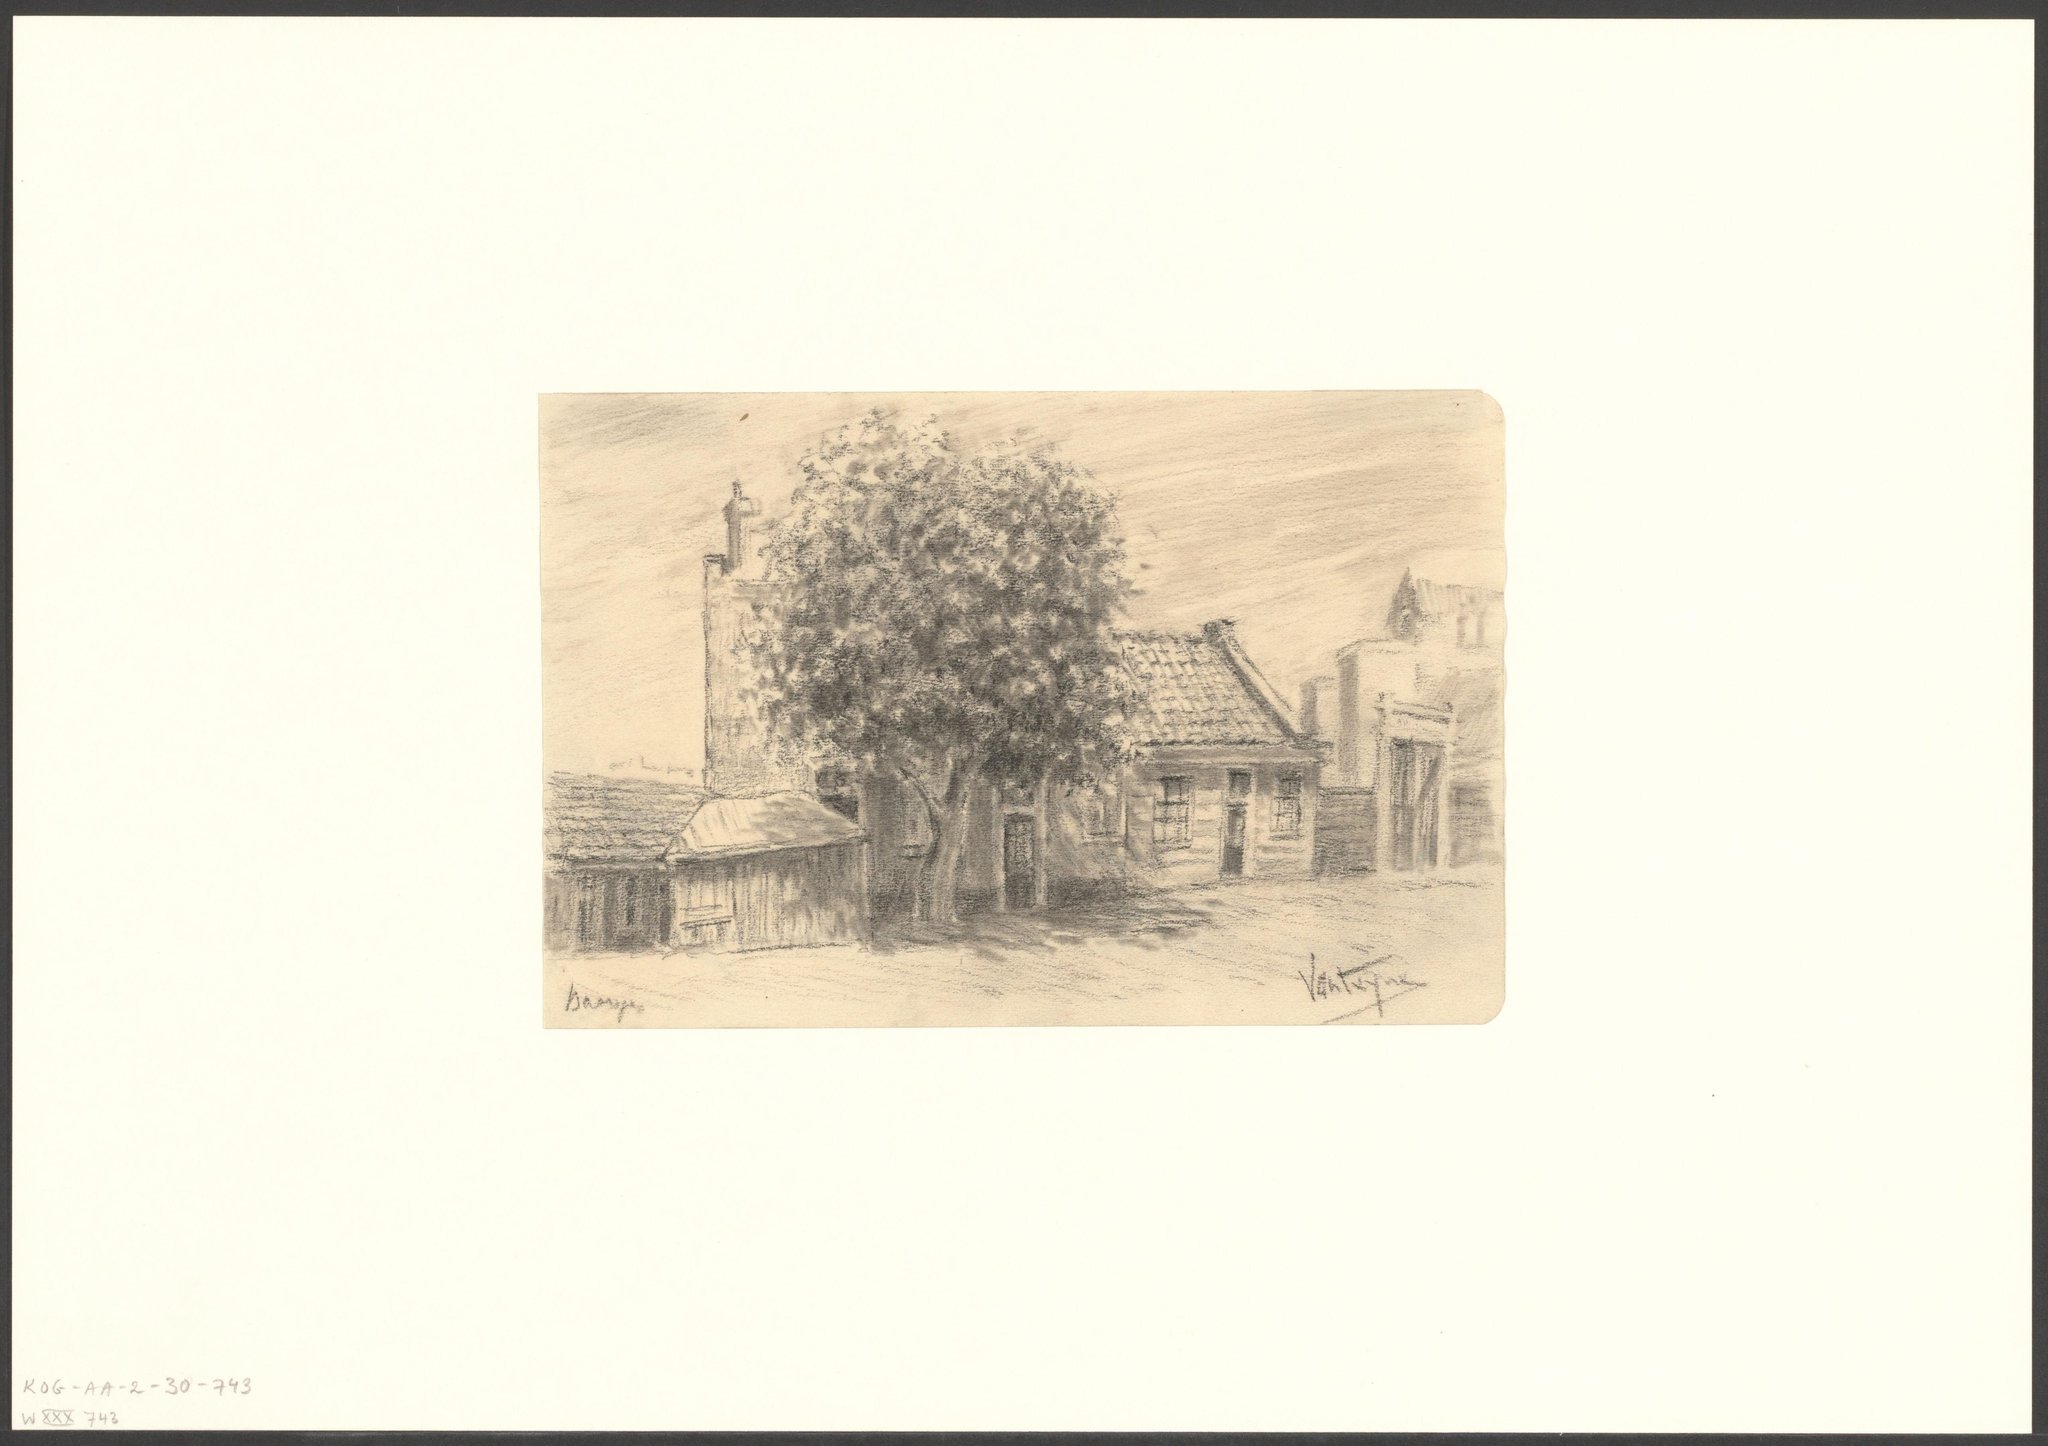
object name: drawing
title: Gezicht op de Baarsjesweg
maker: anthonie van teijn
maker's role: draughtsman, painter, print maker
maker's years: 1863-1943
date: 1906-1927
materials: chalk, paper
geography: amsterdam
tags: city-view in general; 'veduta', road, path, façade (of house or building)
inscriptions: inscription: ‘Baarsjes weg. 130 (...) Juni 1927. / vanEck’, collector's mark: Lugt 800a, inscription: ‘Baarsjes’, signature: ‘VanTeyne’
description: Tekening binnen de Atlas Van Eck ingedeeld op wijknummer 30.